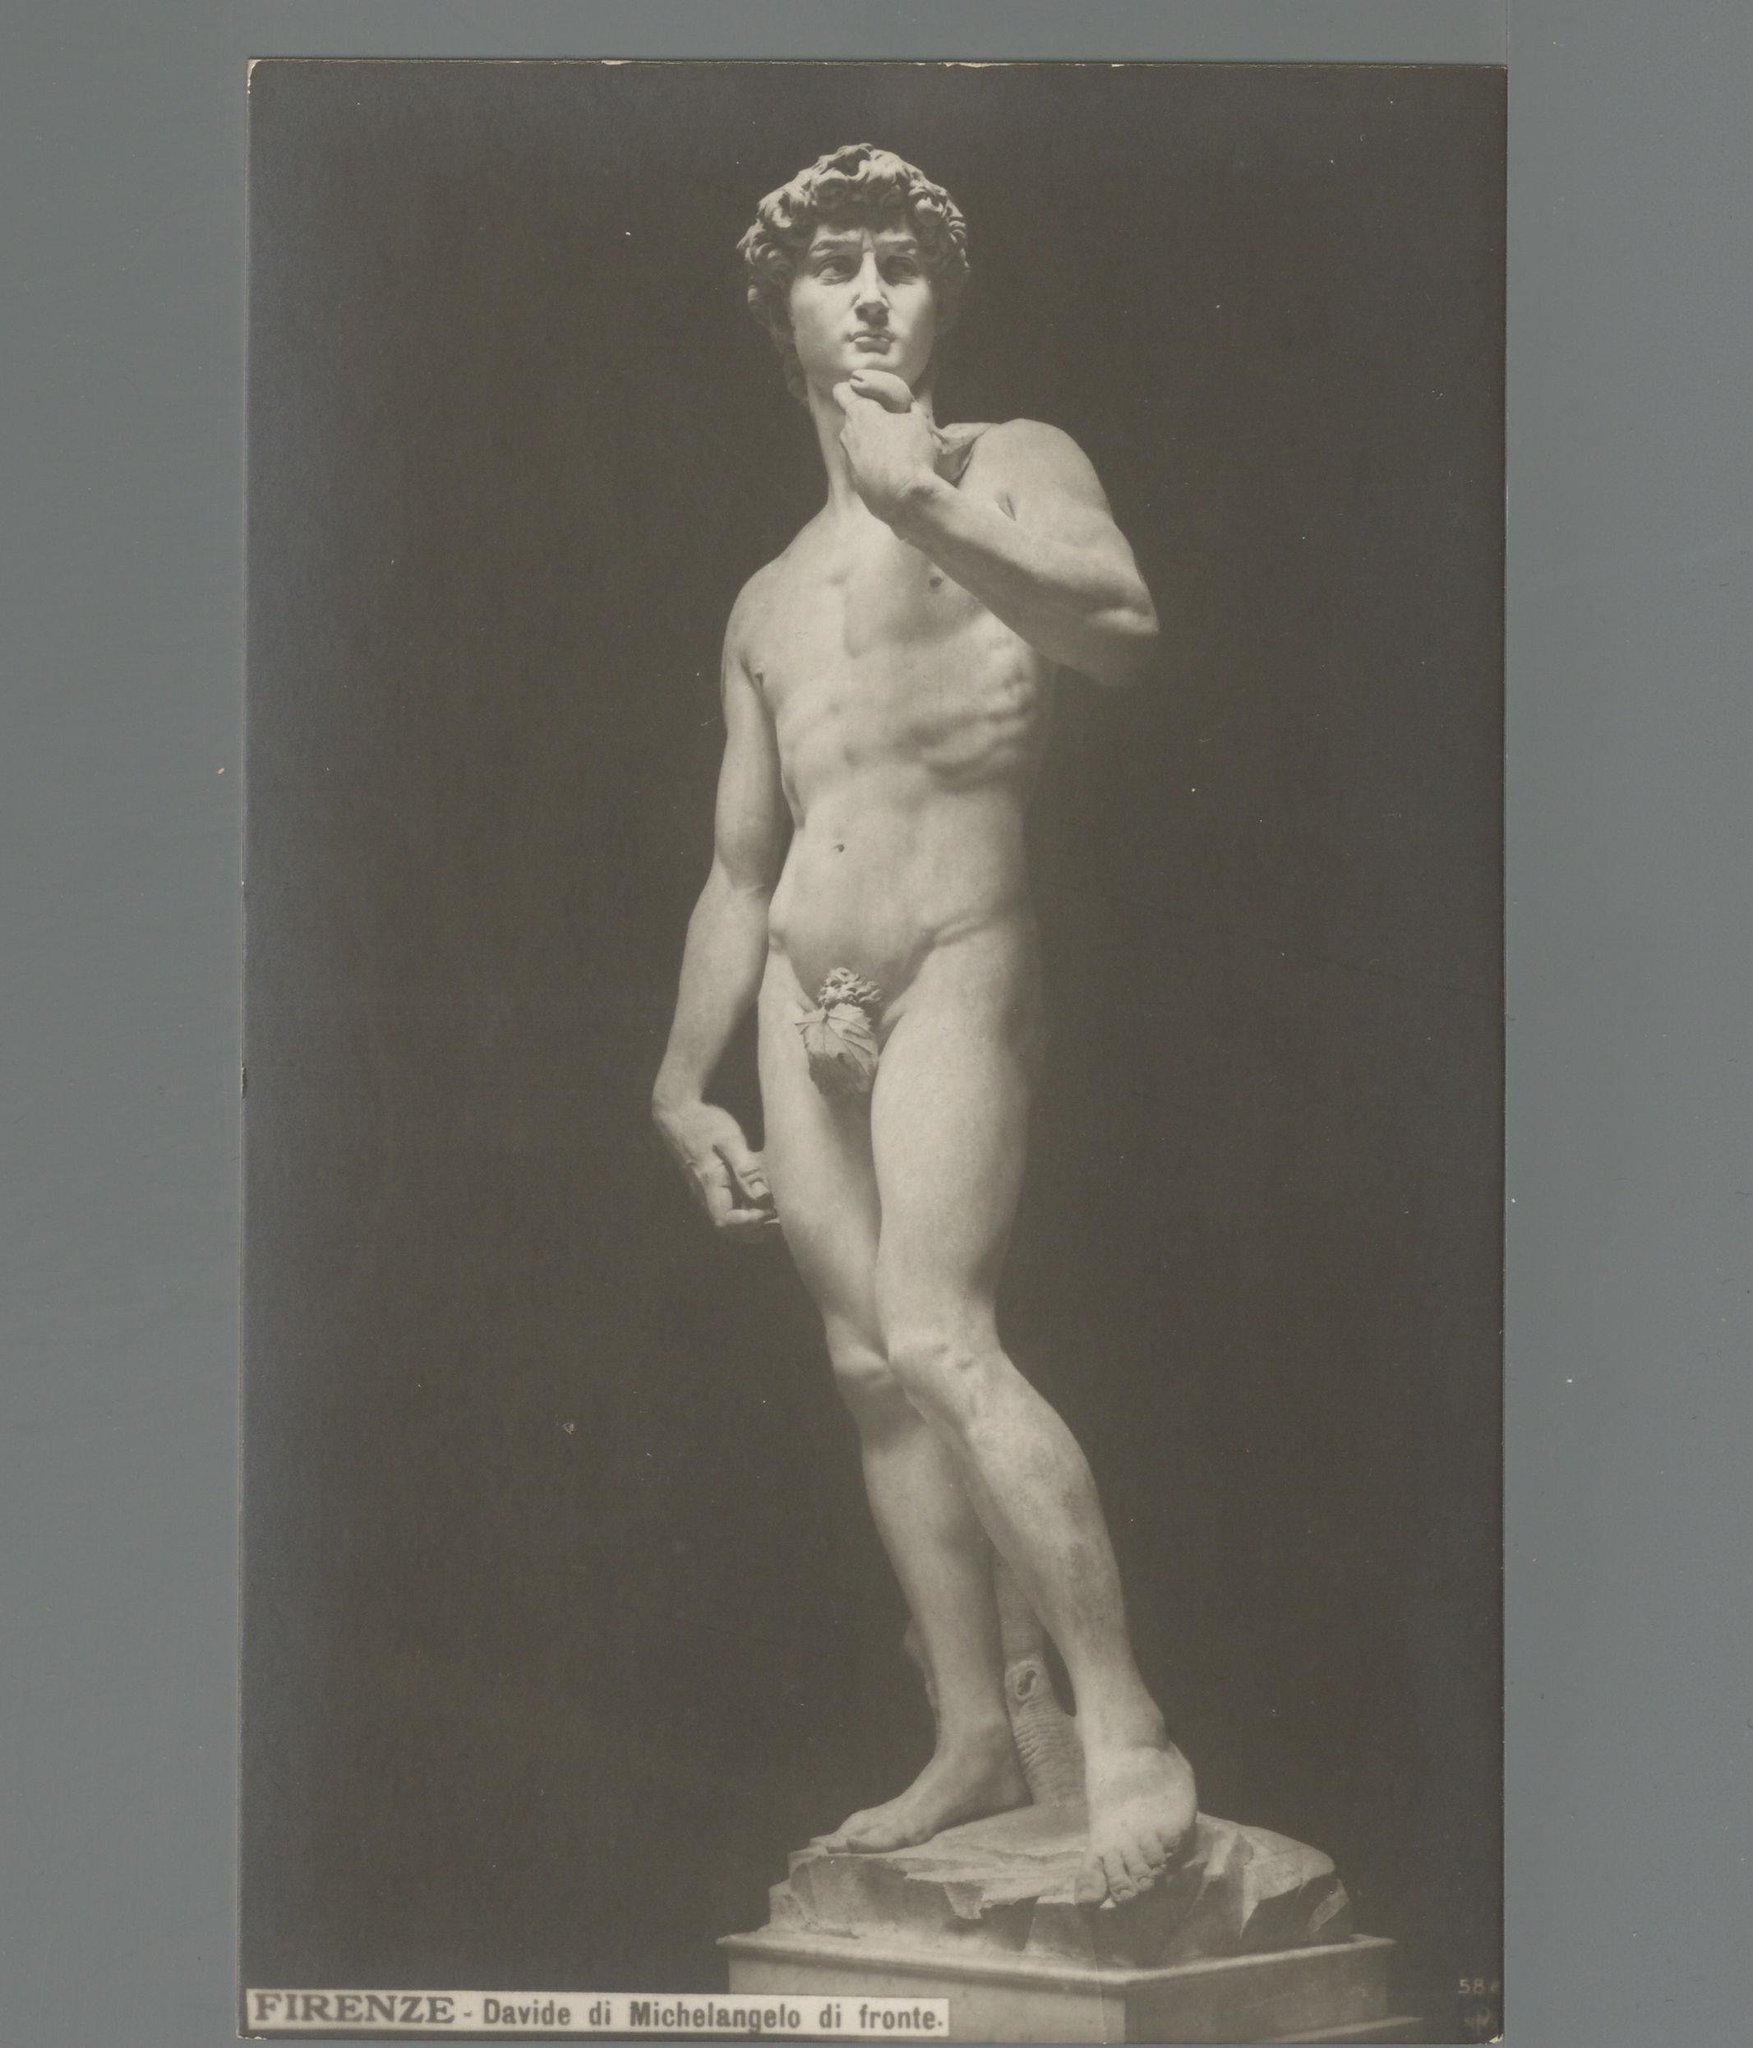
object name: ansichtkaart, prentbriefkaart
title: Firenze. Davide di Michelangelo di fronte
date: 1906-1920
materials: paper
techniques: gelatin silver print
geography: italy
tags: sculpture